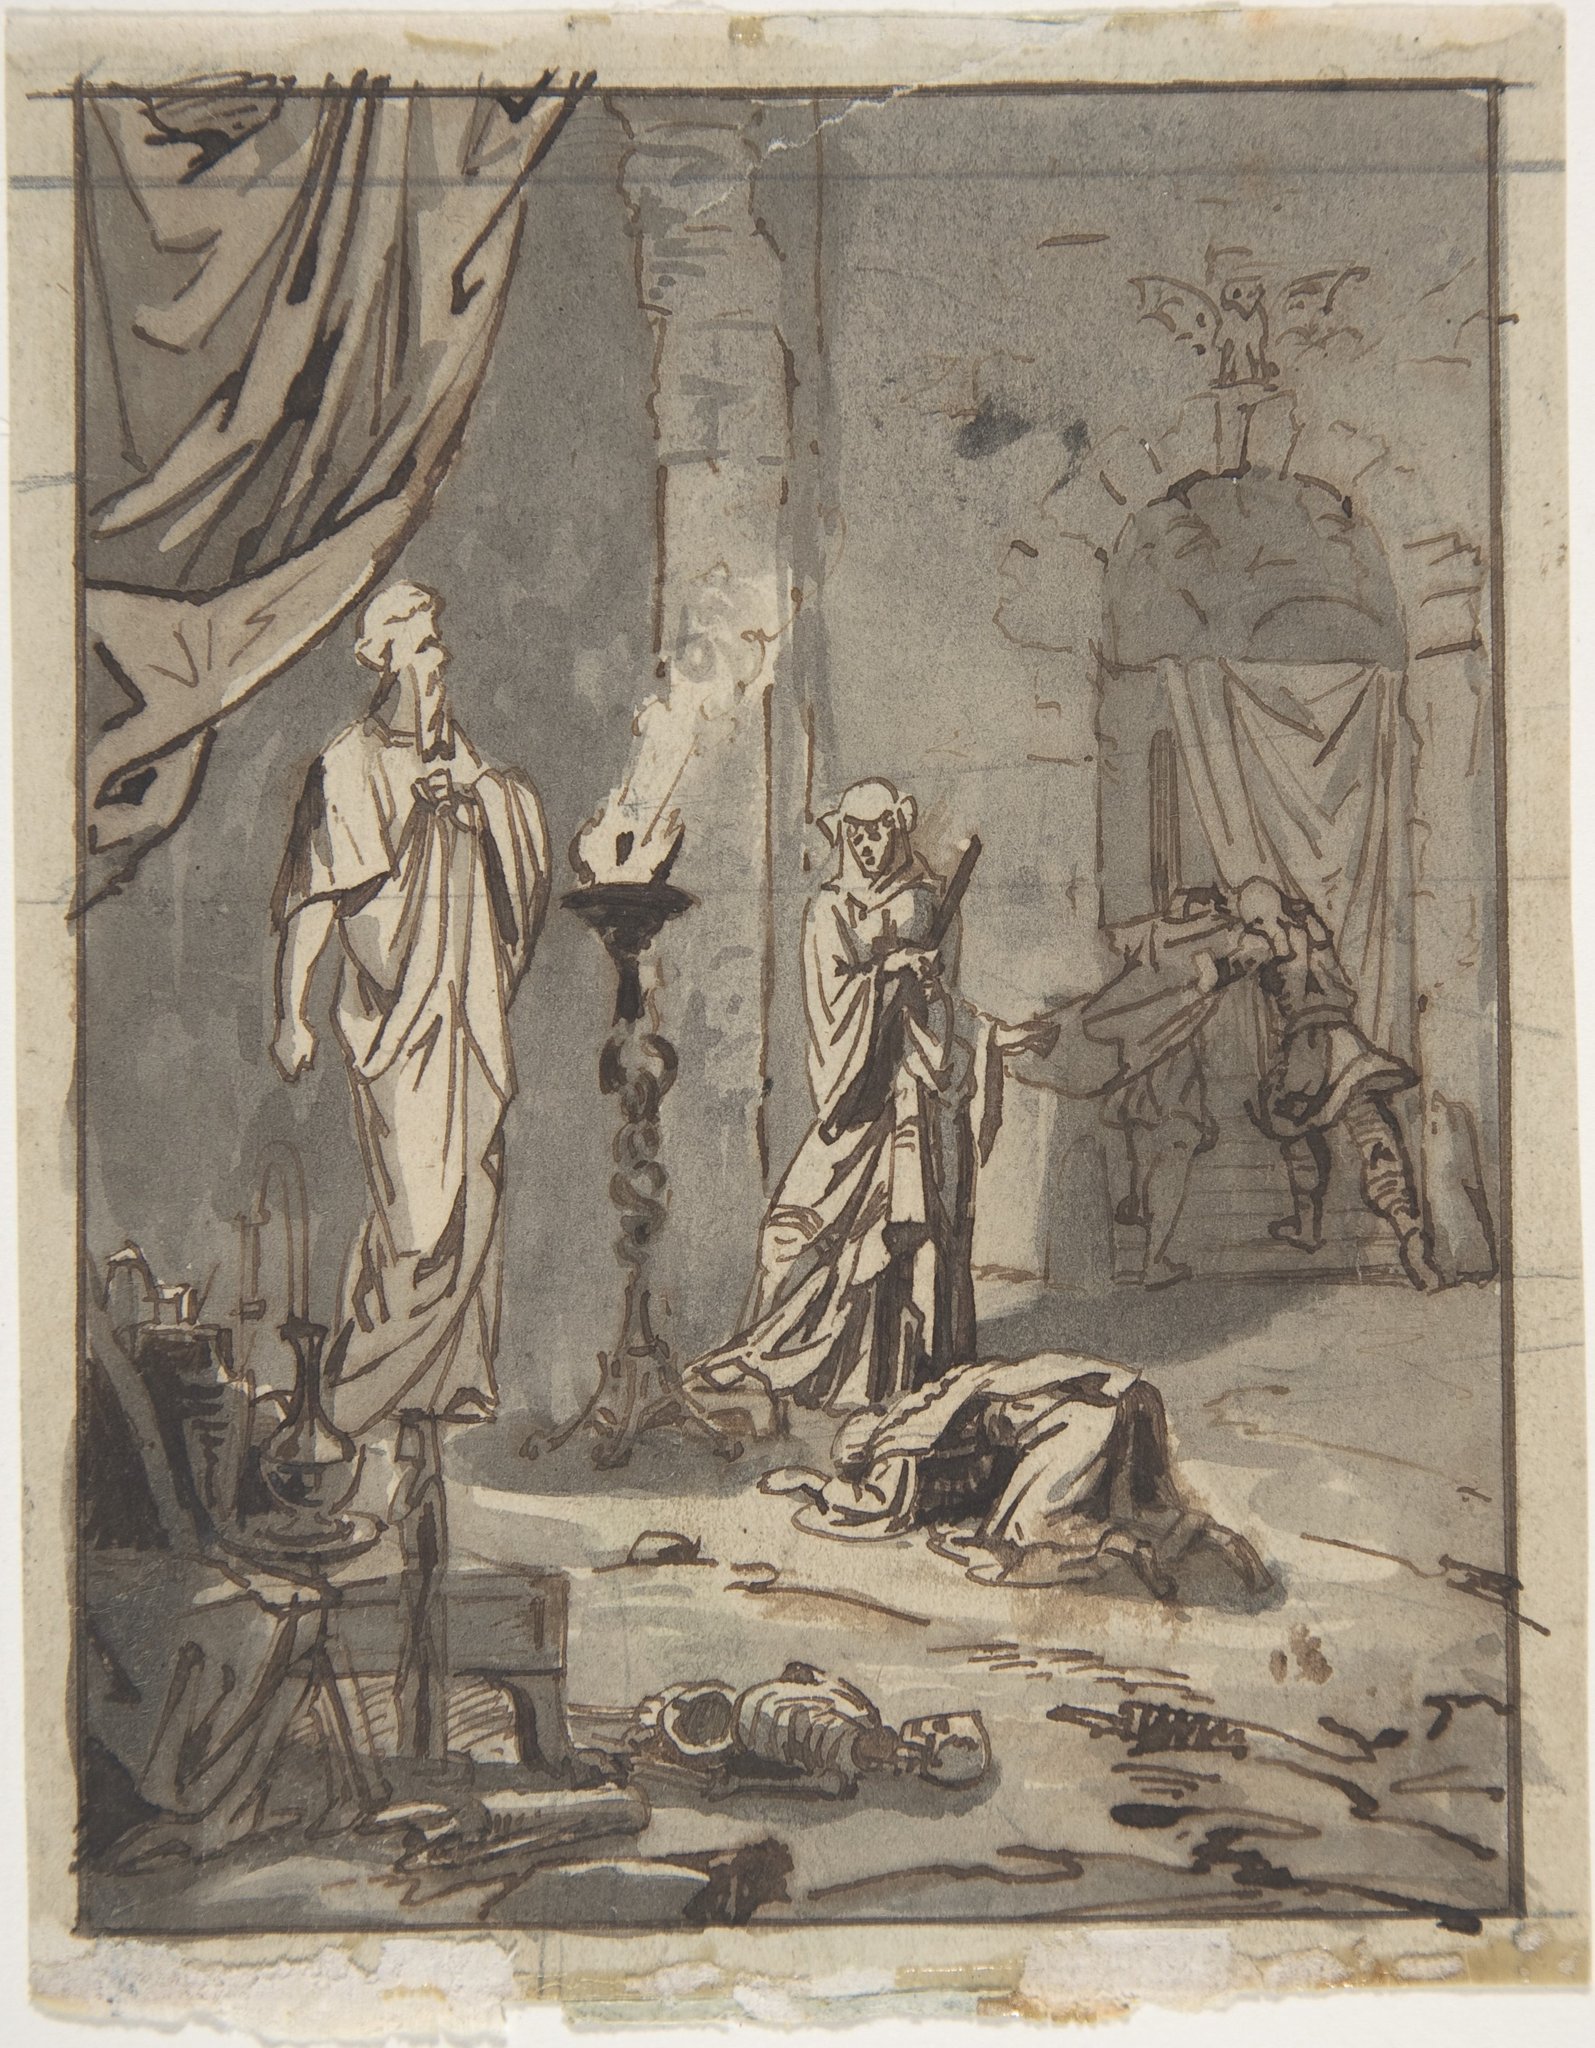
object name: drawing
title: Witch of Endor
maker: ary scheffer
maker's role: artist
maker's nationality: dutch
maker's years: 1795-1858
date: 1801-1900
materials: graphite, ink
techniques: brush, pen, wash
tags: skeletons,men,women,witches